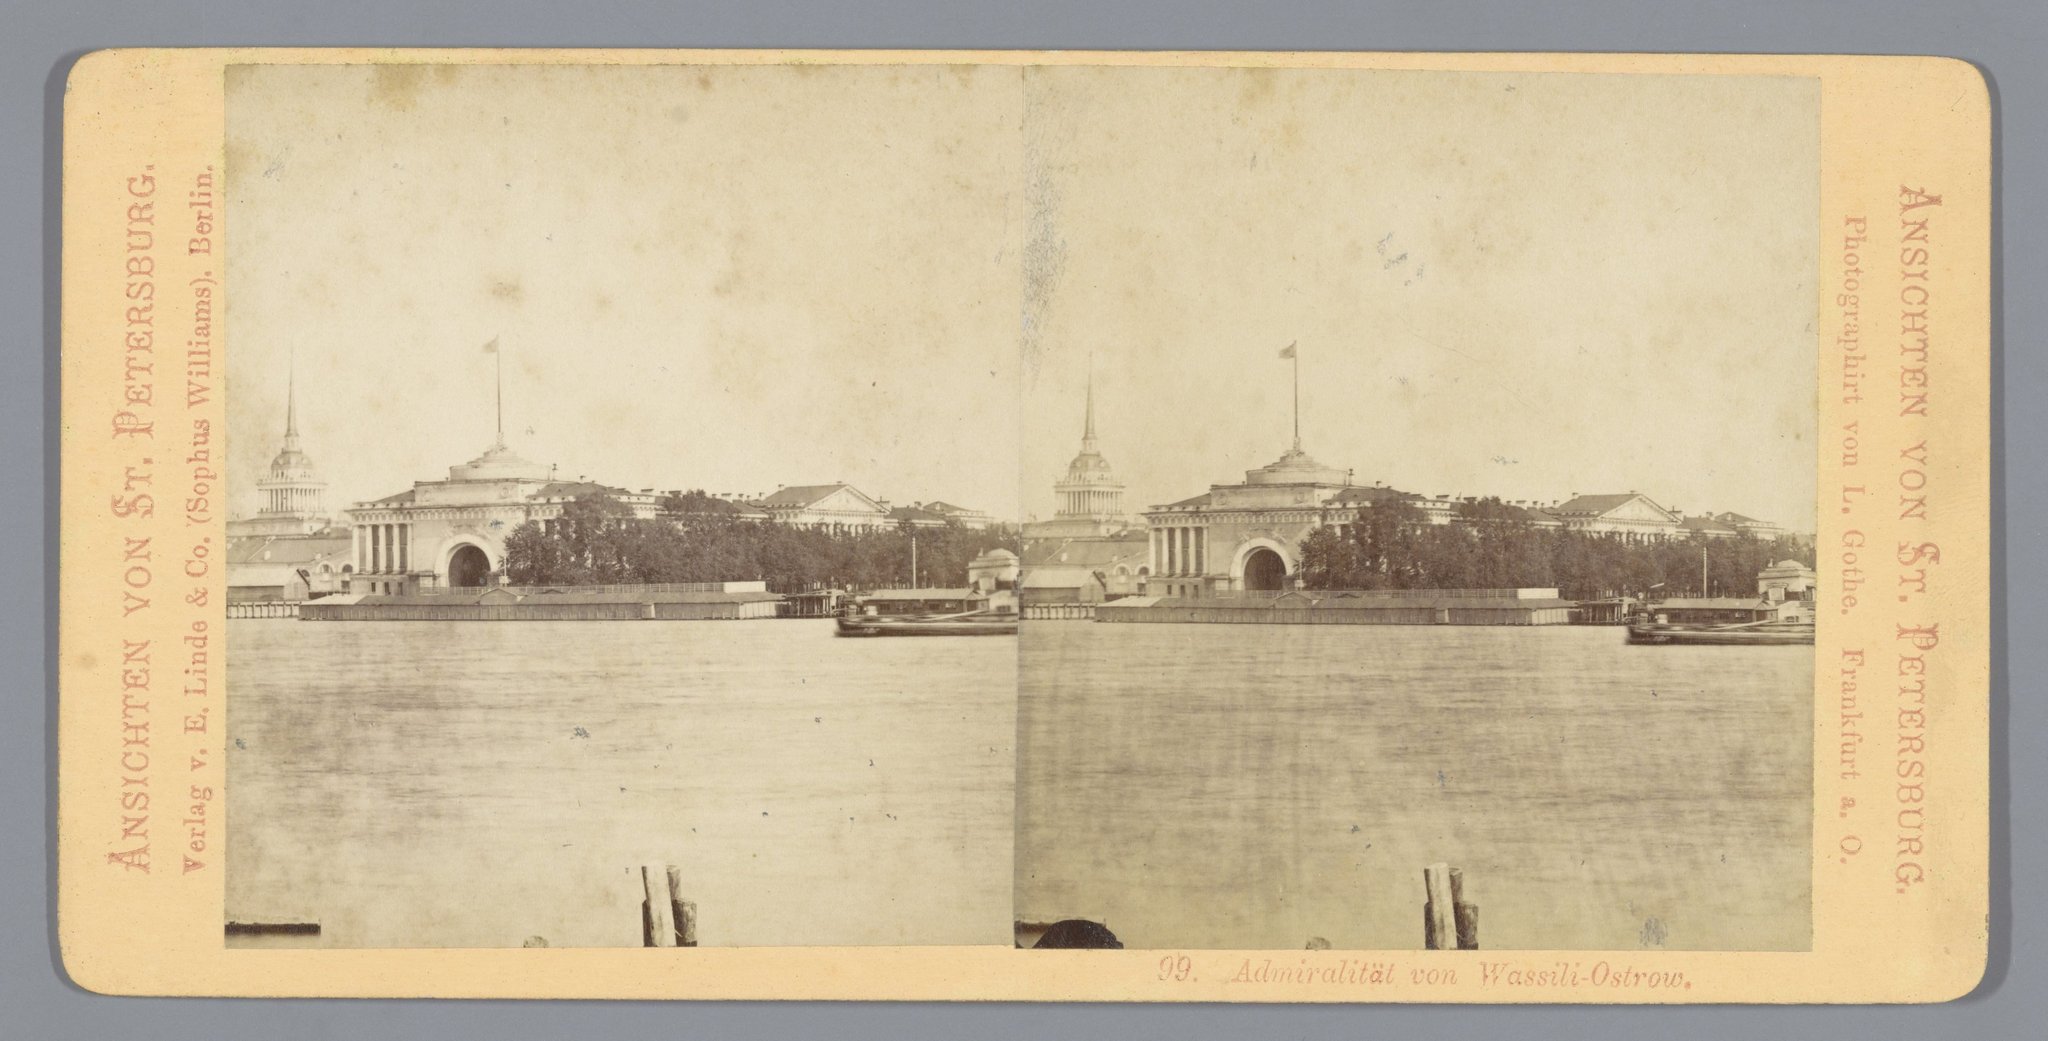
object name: stereograph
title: Admiralität von Wassili-Ostrow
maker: louis gothe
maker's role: fotograaf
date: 1850-1880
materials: cardboard, photographic support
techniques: albumen print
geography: sint-petersburg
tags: river, dome ~ architecture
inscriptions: inscription: ‘Ansichten von St. Petersburg.’, number: ‘99.’